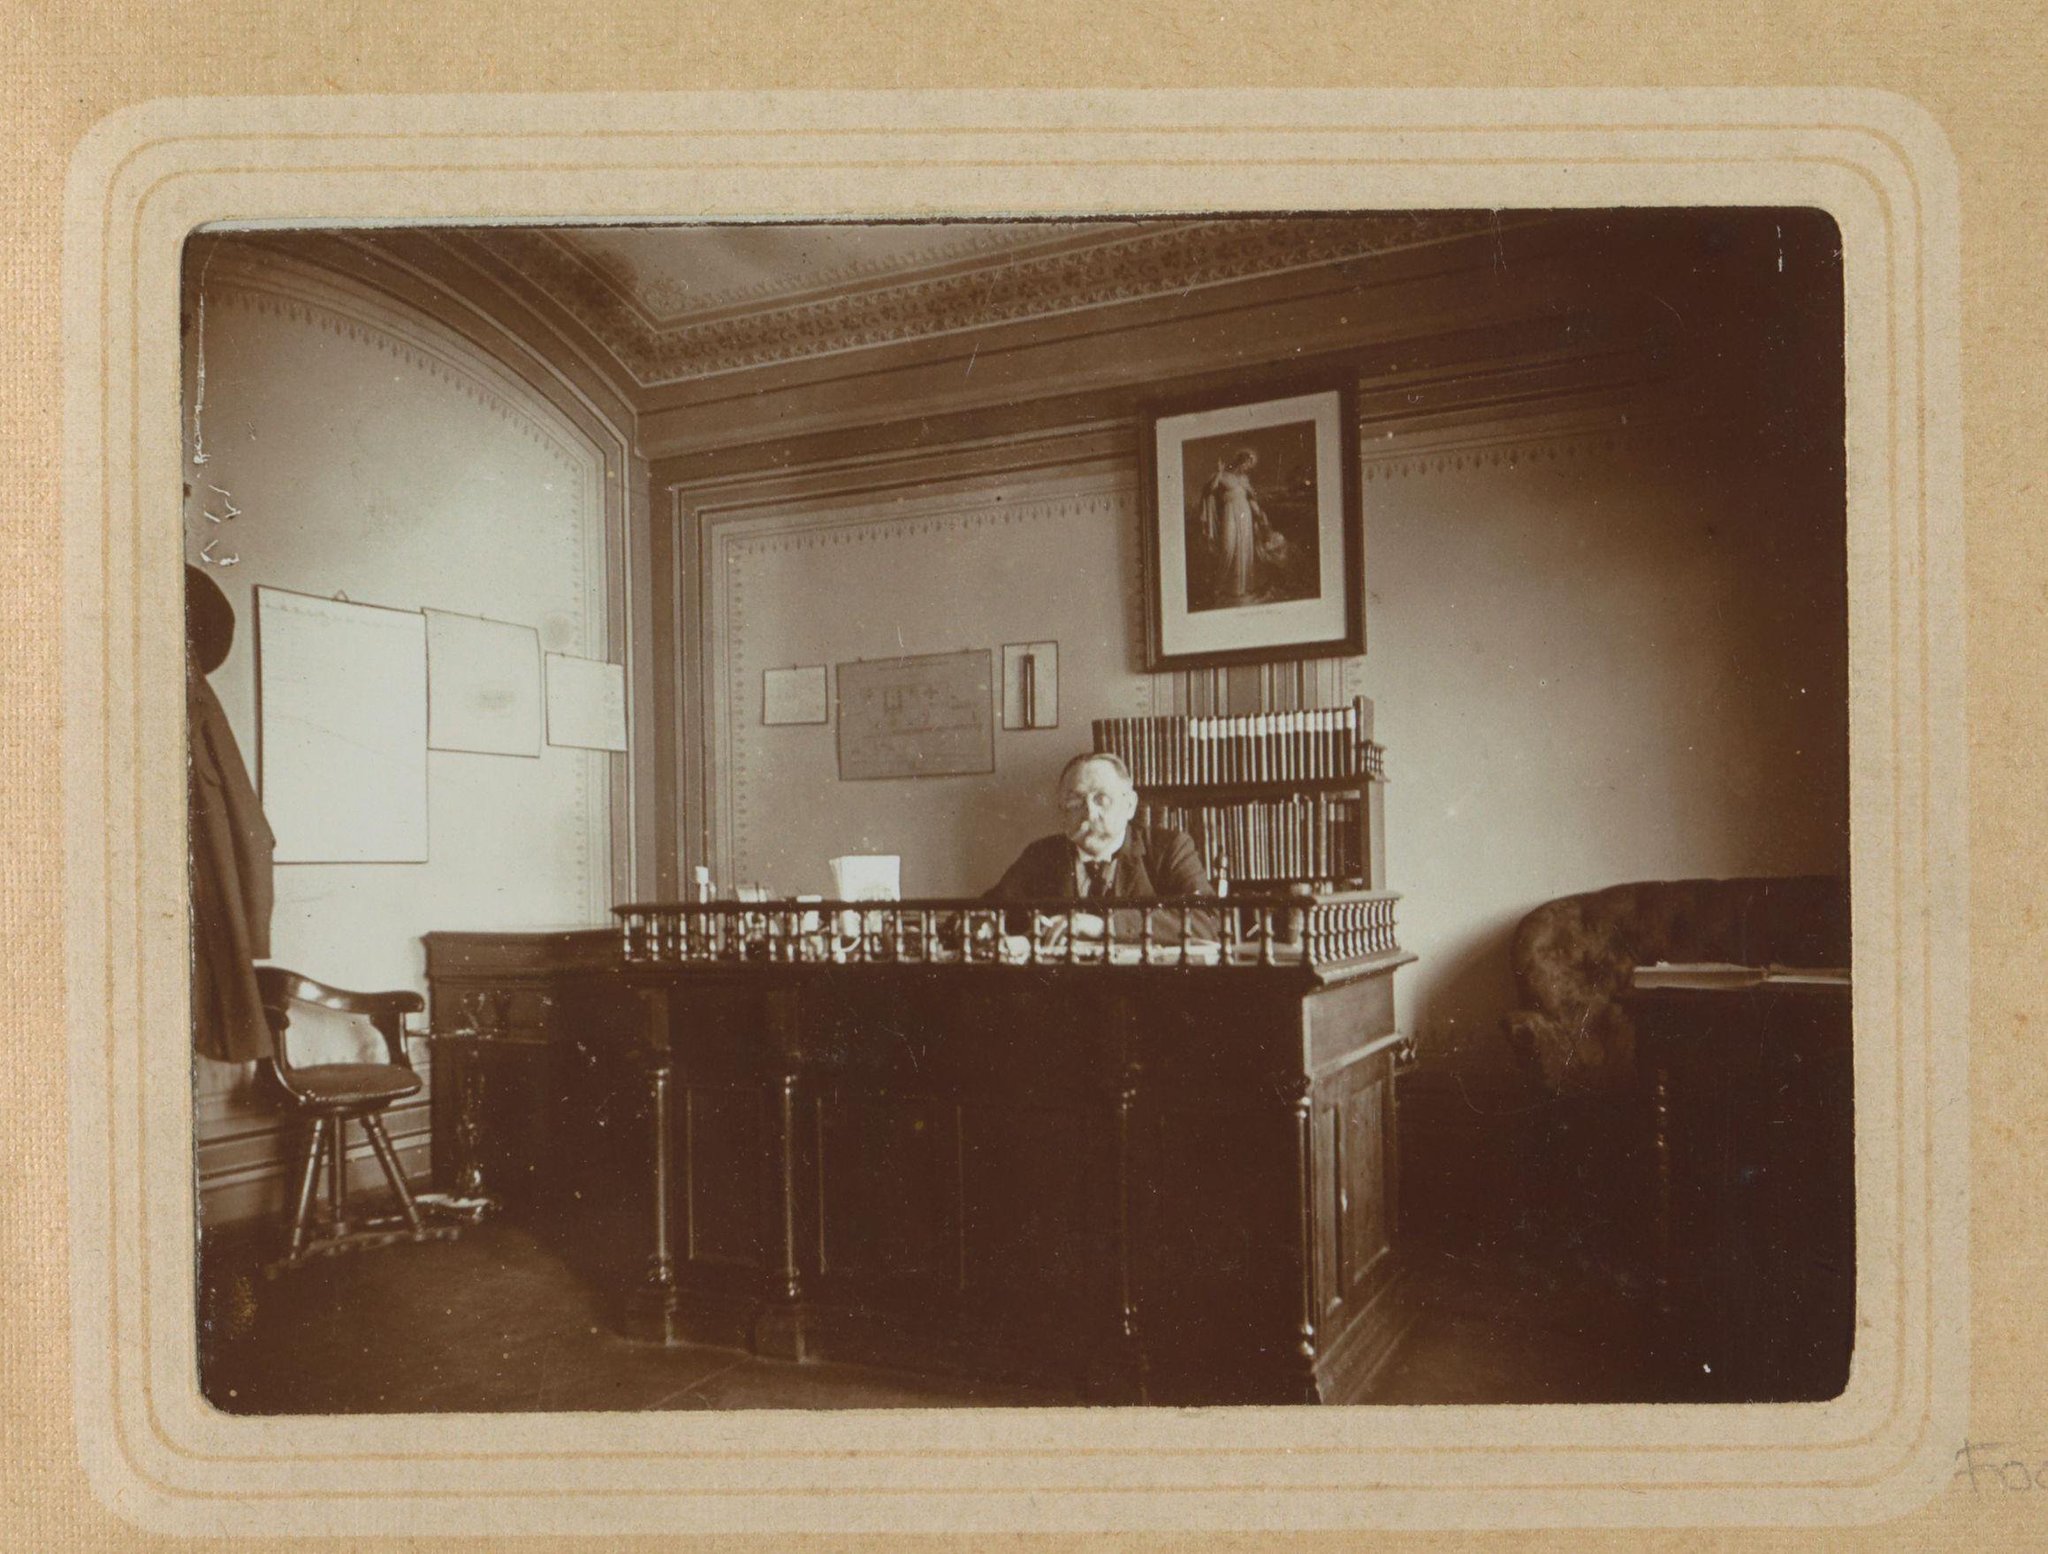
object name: photograph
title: Portret van een man achter een bureau in een kamer in Duitsland met aan de muur een plattegrond en een afbeelding van Christus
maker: Anonymous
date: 1890-1910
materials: cardboard, paper, photographic support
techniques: collodion silver print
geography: germany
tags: writing-table, writing-desk, maps, atlases, adult man, christ, germany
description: Onderdeel van Fotoalbum van Carl Heinrich Fliegenschmidt, gevangenisdirecteur te Oslebshausen.